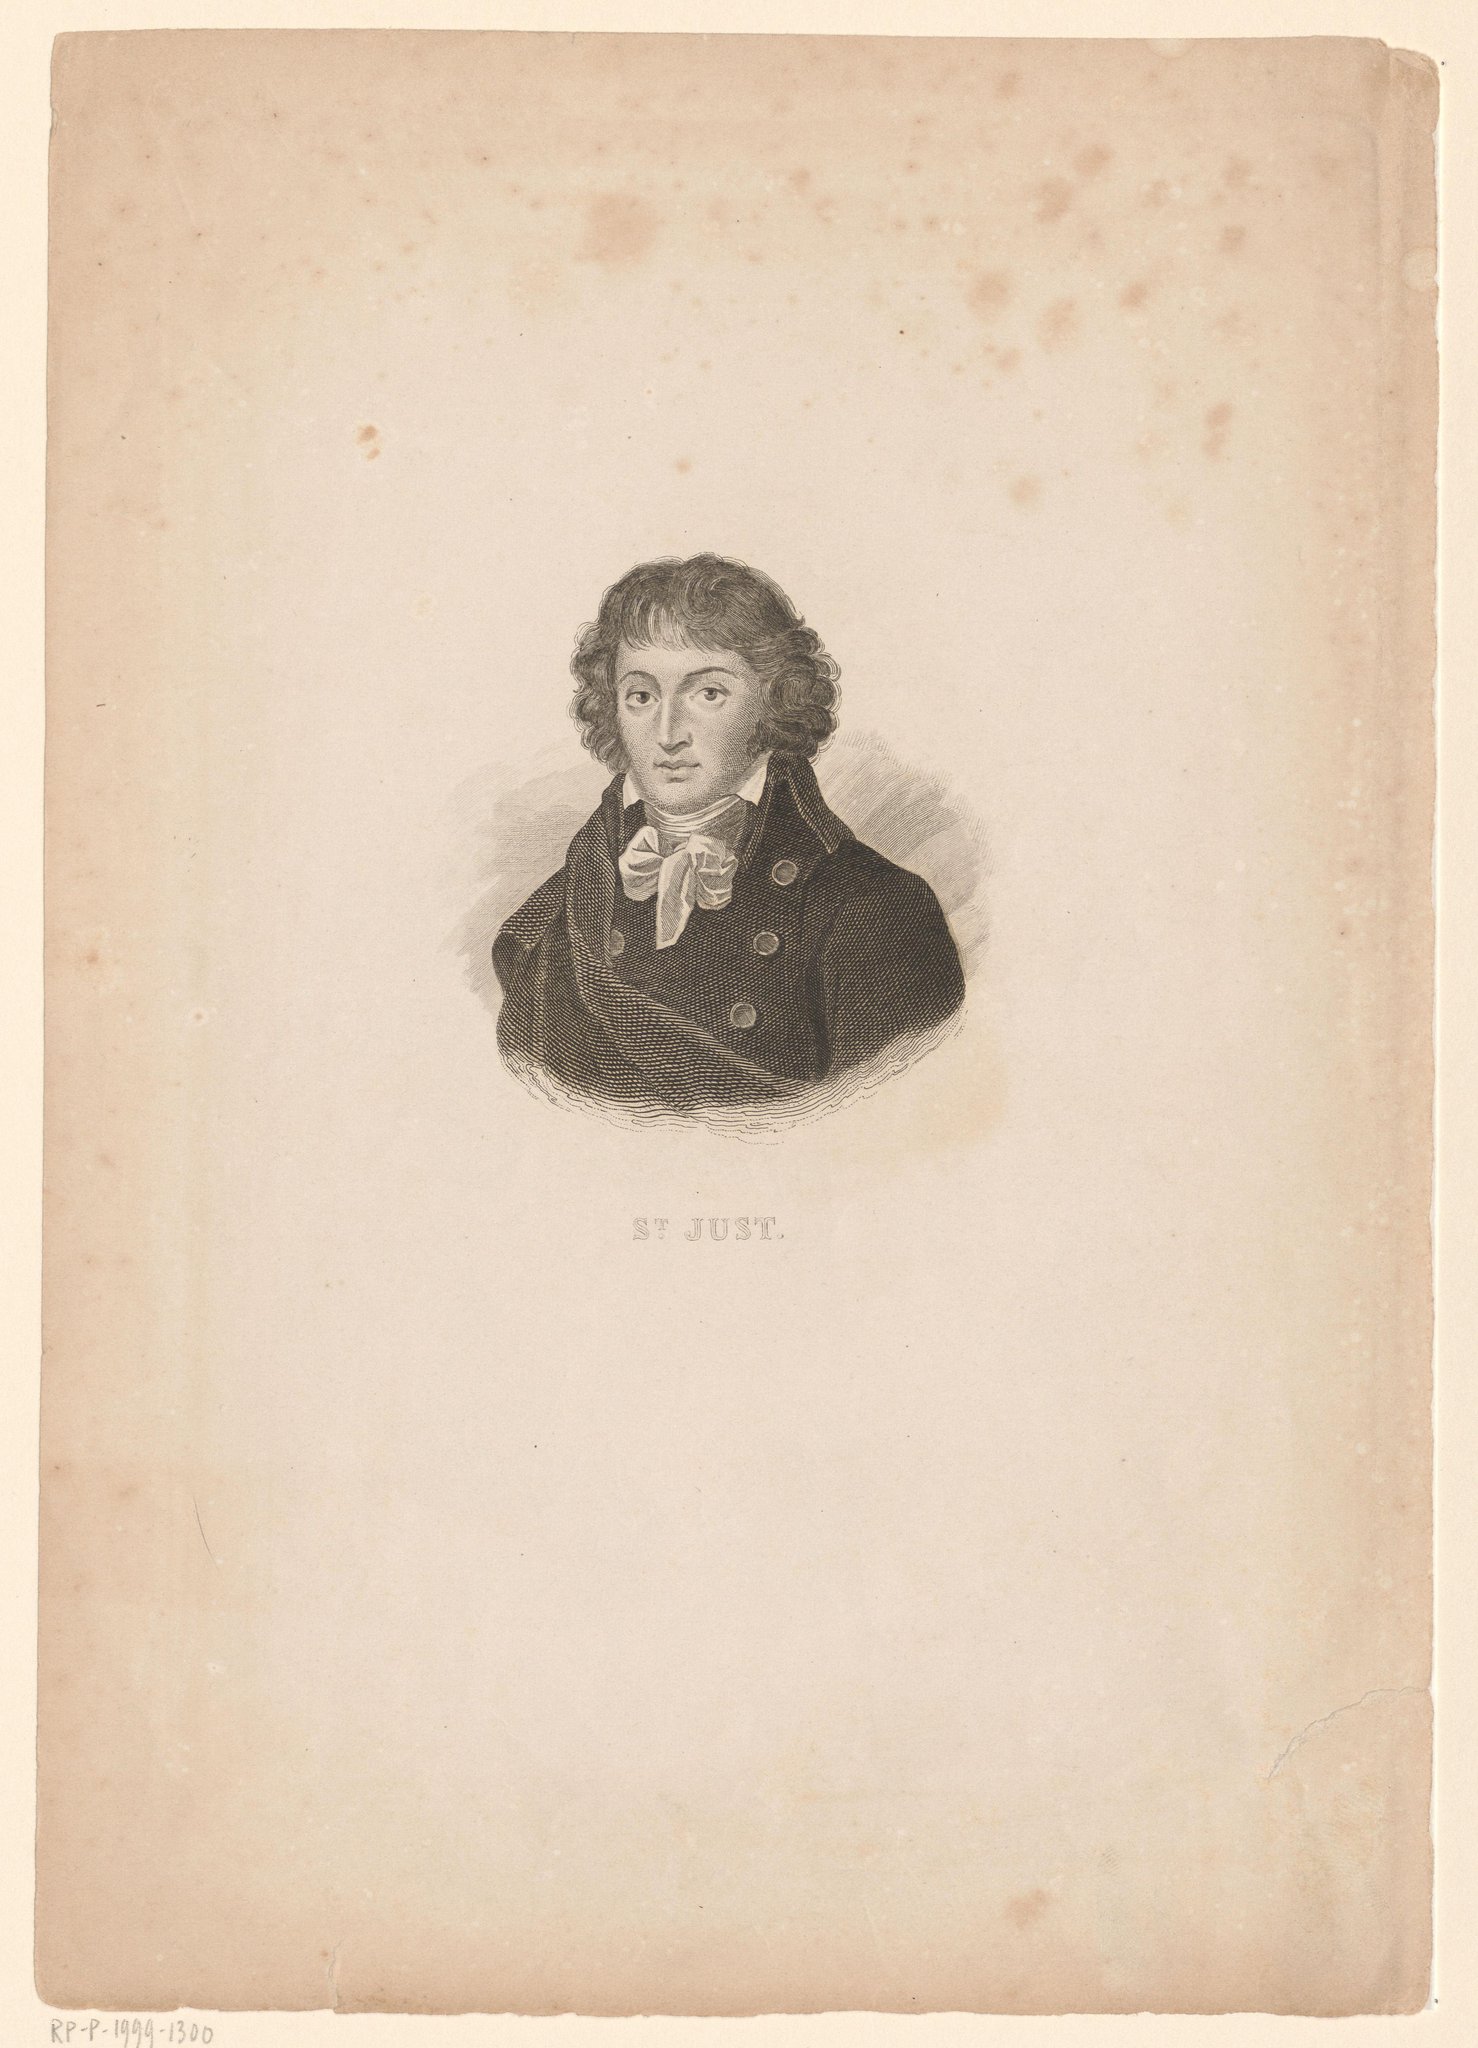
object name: print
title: Portret van Louis Antoine Leon de Saint-Just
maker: Anonymous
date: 1786-1849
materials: paper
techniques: engraving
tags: paris, politician, historical persons, politician, e.g. party leader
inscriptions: collector's mark: Lugt 2228, collector's mark: Lugt 2760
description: Louis Antoine Leon de Saint-Just. (1767 -1794) Frans politicus (Jacobijn). Buste naar links.